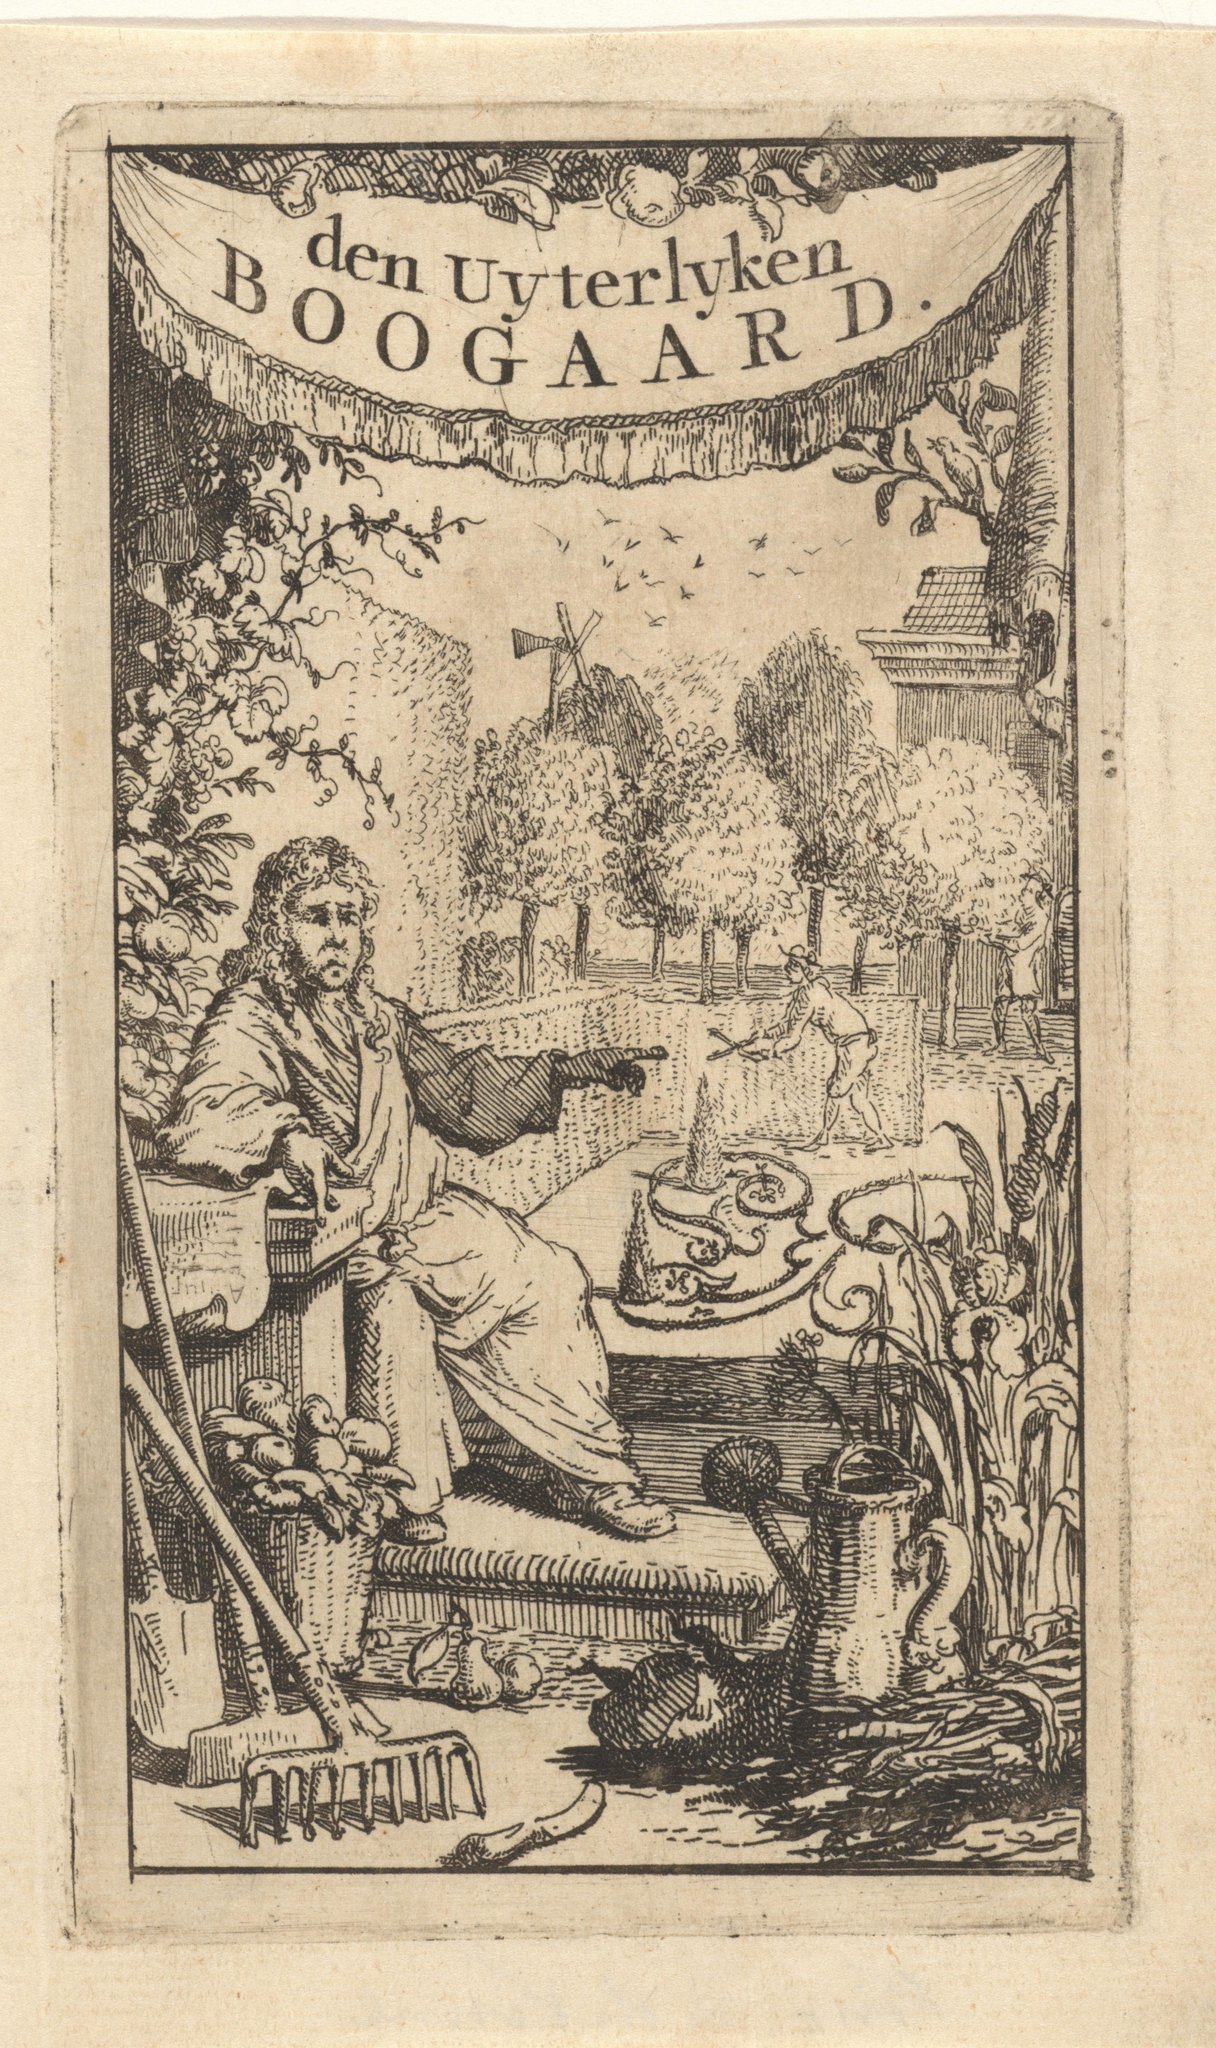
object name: print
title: Titelpagina voor: A. van den Abeele, Den Uyterlyken Boogaard, 1730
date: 1730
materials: paper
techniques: etching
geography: haarlem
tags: cultivation of (ornamental) garden, gardening-tools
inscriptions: collector's mark: Lugt 2228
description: Eeen man, zittend in een tuin, wijst met zijn ene hand naar tuingereedschap op de voorgrond, en met de andere hand naar de tuin achter hem, waar twee mannen bomen en een heg snoeien.